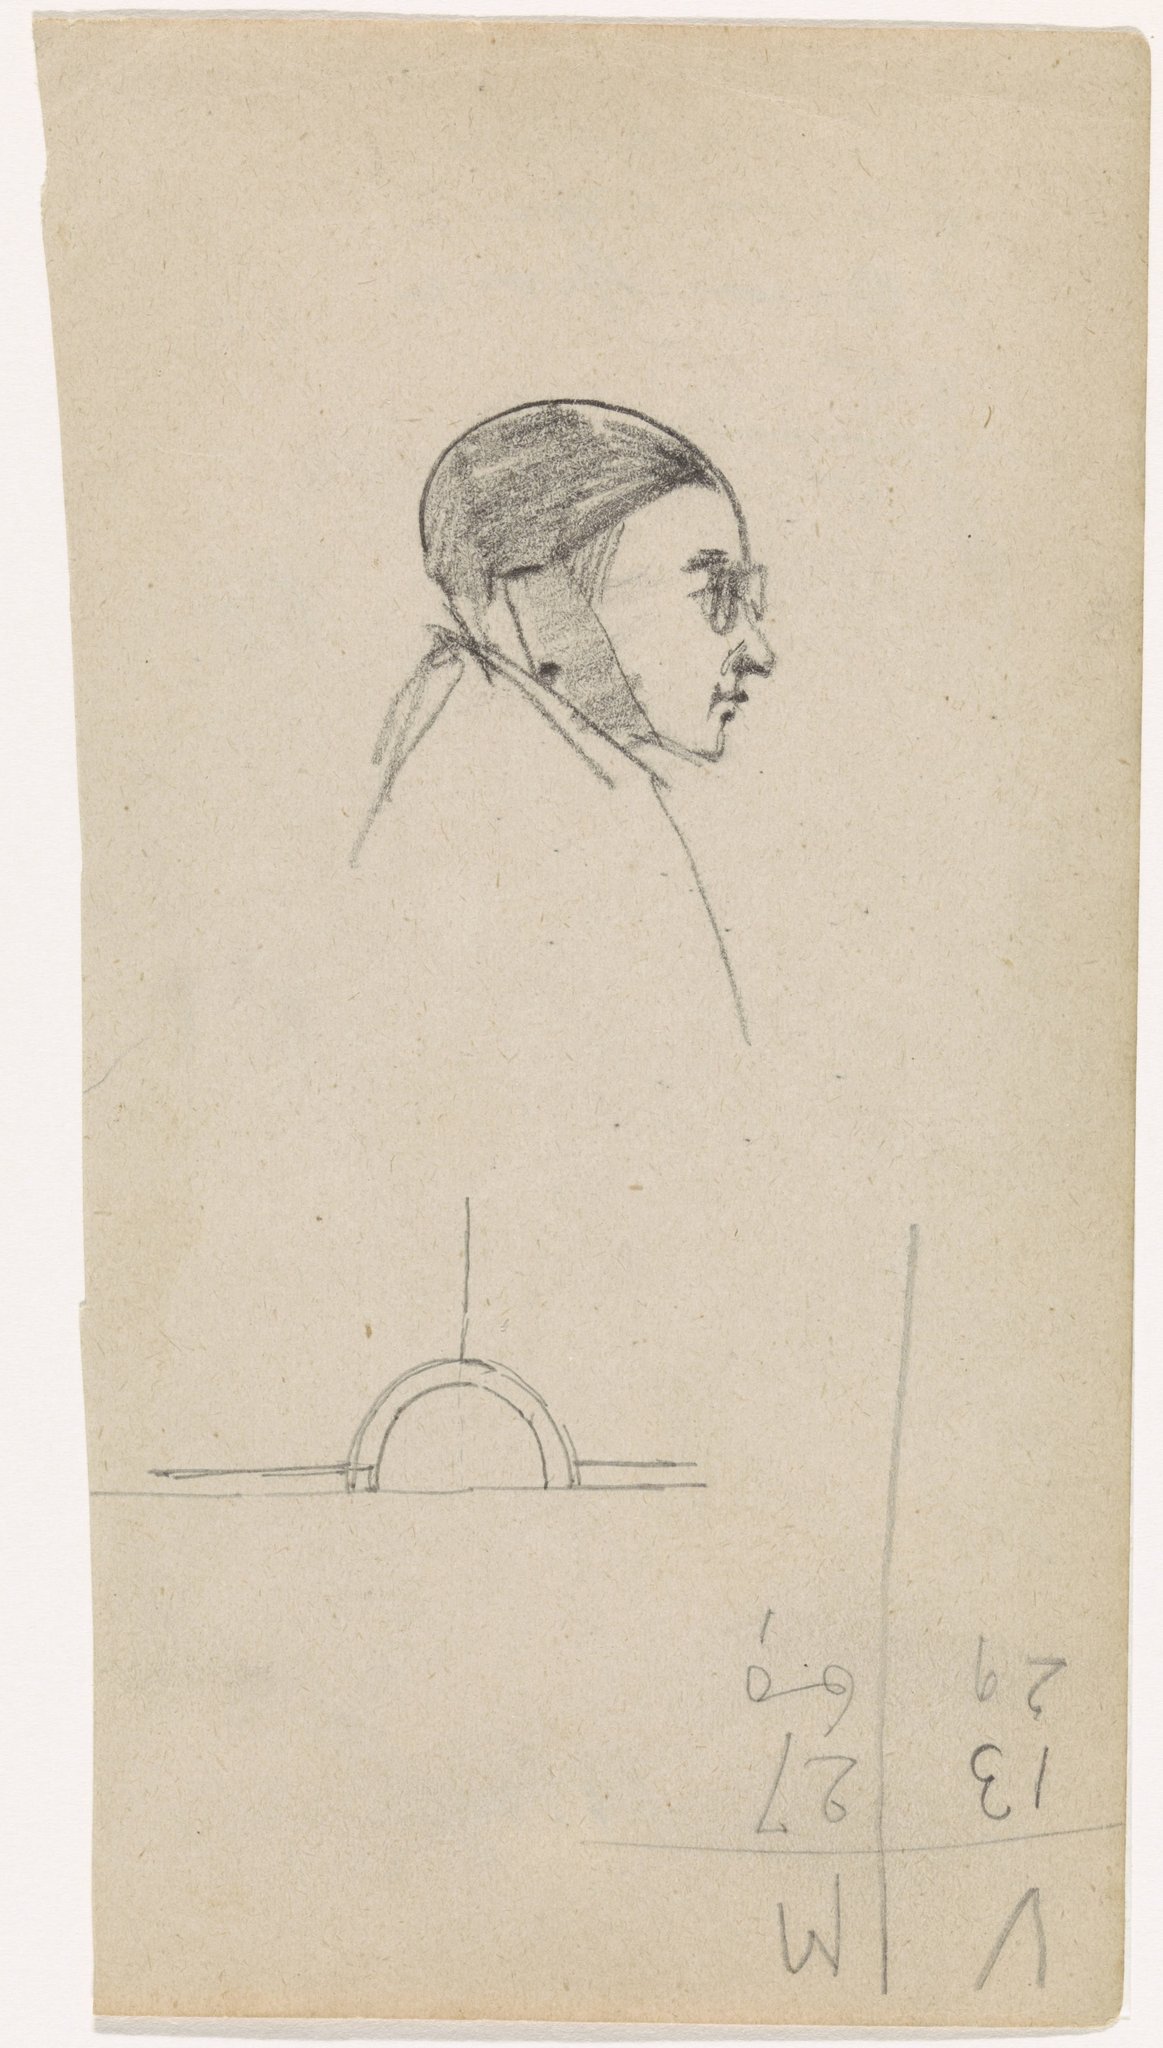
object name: drawing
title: Man met verband om het hoofd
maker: gerrit willem dijsselhof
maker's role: designer, draughtsman, print maker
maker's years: 1866-1924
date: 1876-1924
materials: chalk, paper